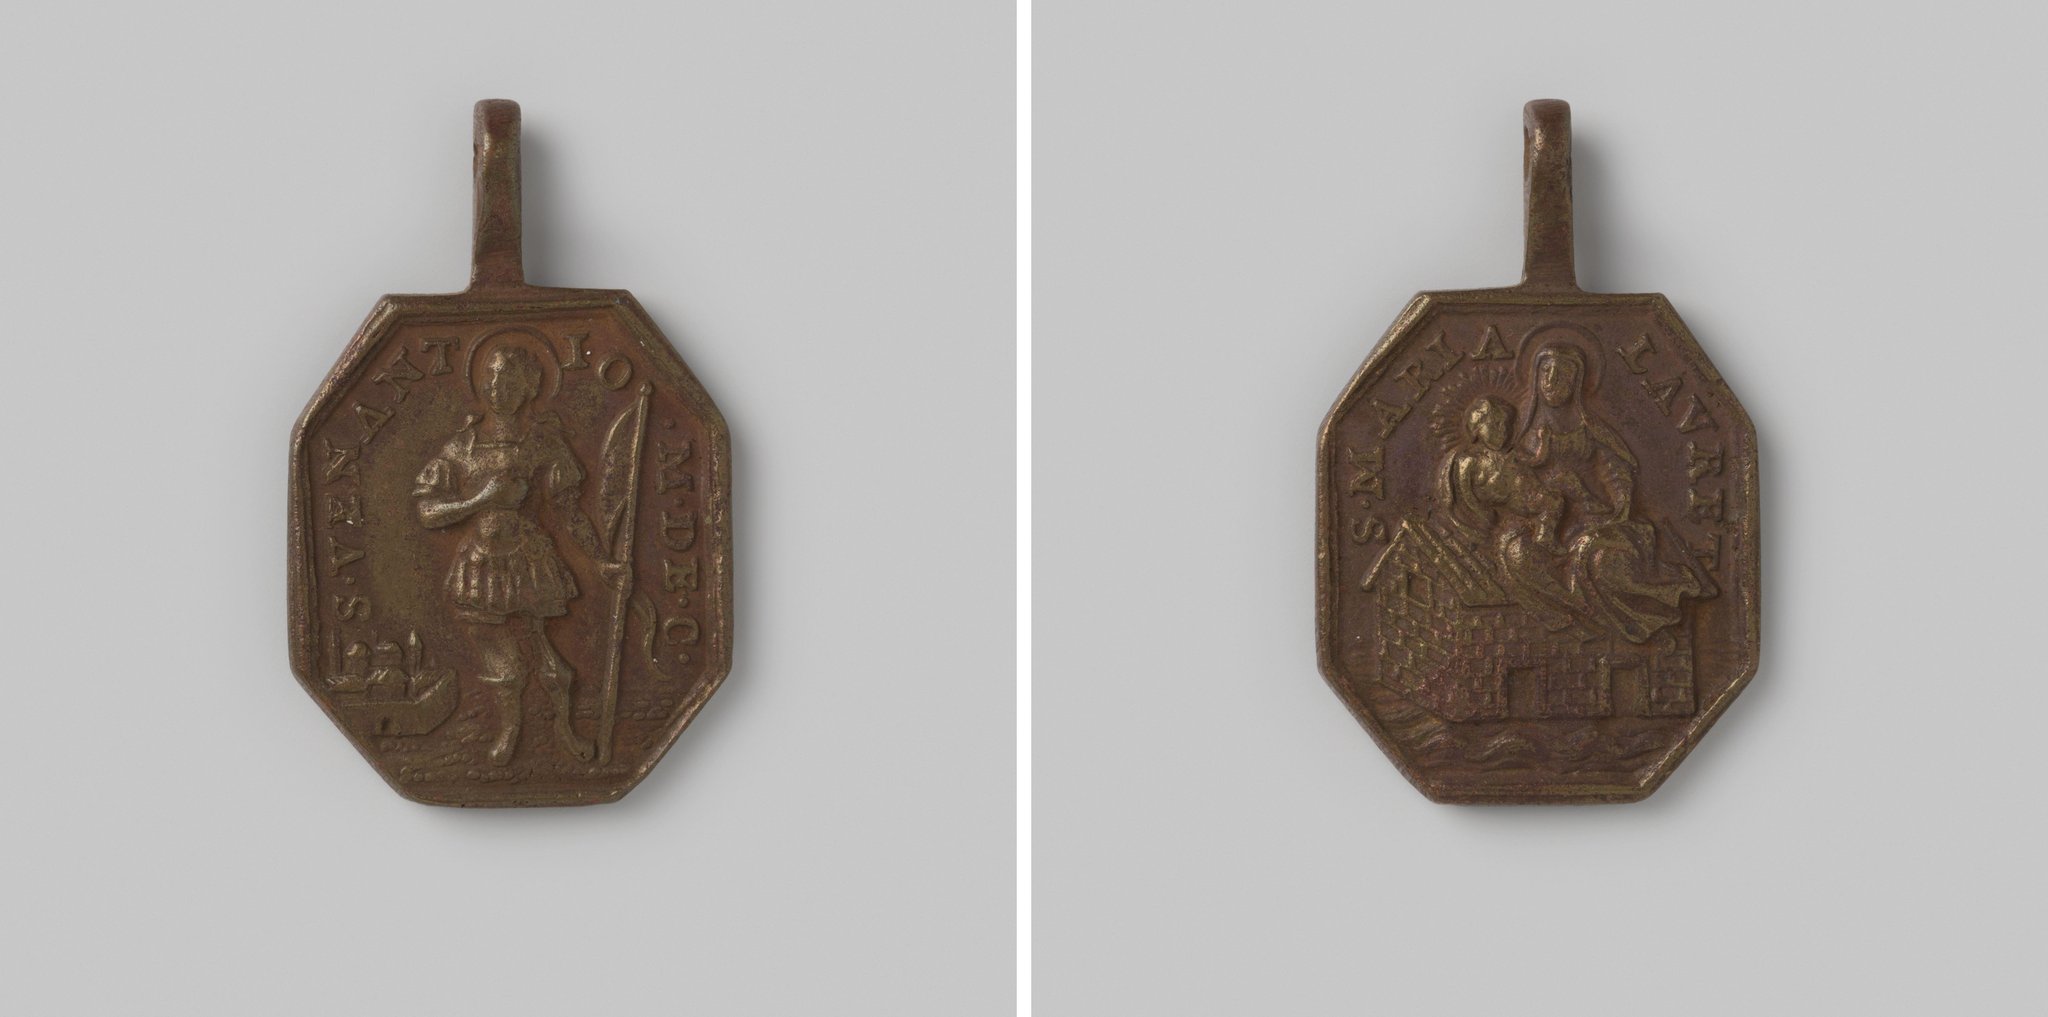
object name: history medal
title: Religieus draagteken met S. Venantius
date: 1700-1800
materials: brass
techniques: casting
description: Achthoekige messing penning aan draagoog, op de voorzijde Sint Venantius in harnas staand met vlag, met omschrift, op de keerzijde Maria met Kind boven huis in rivier, met omschrift.